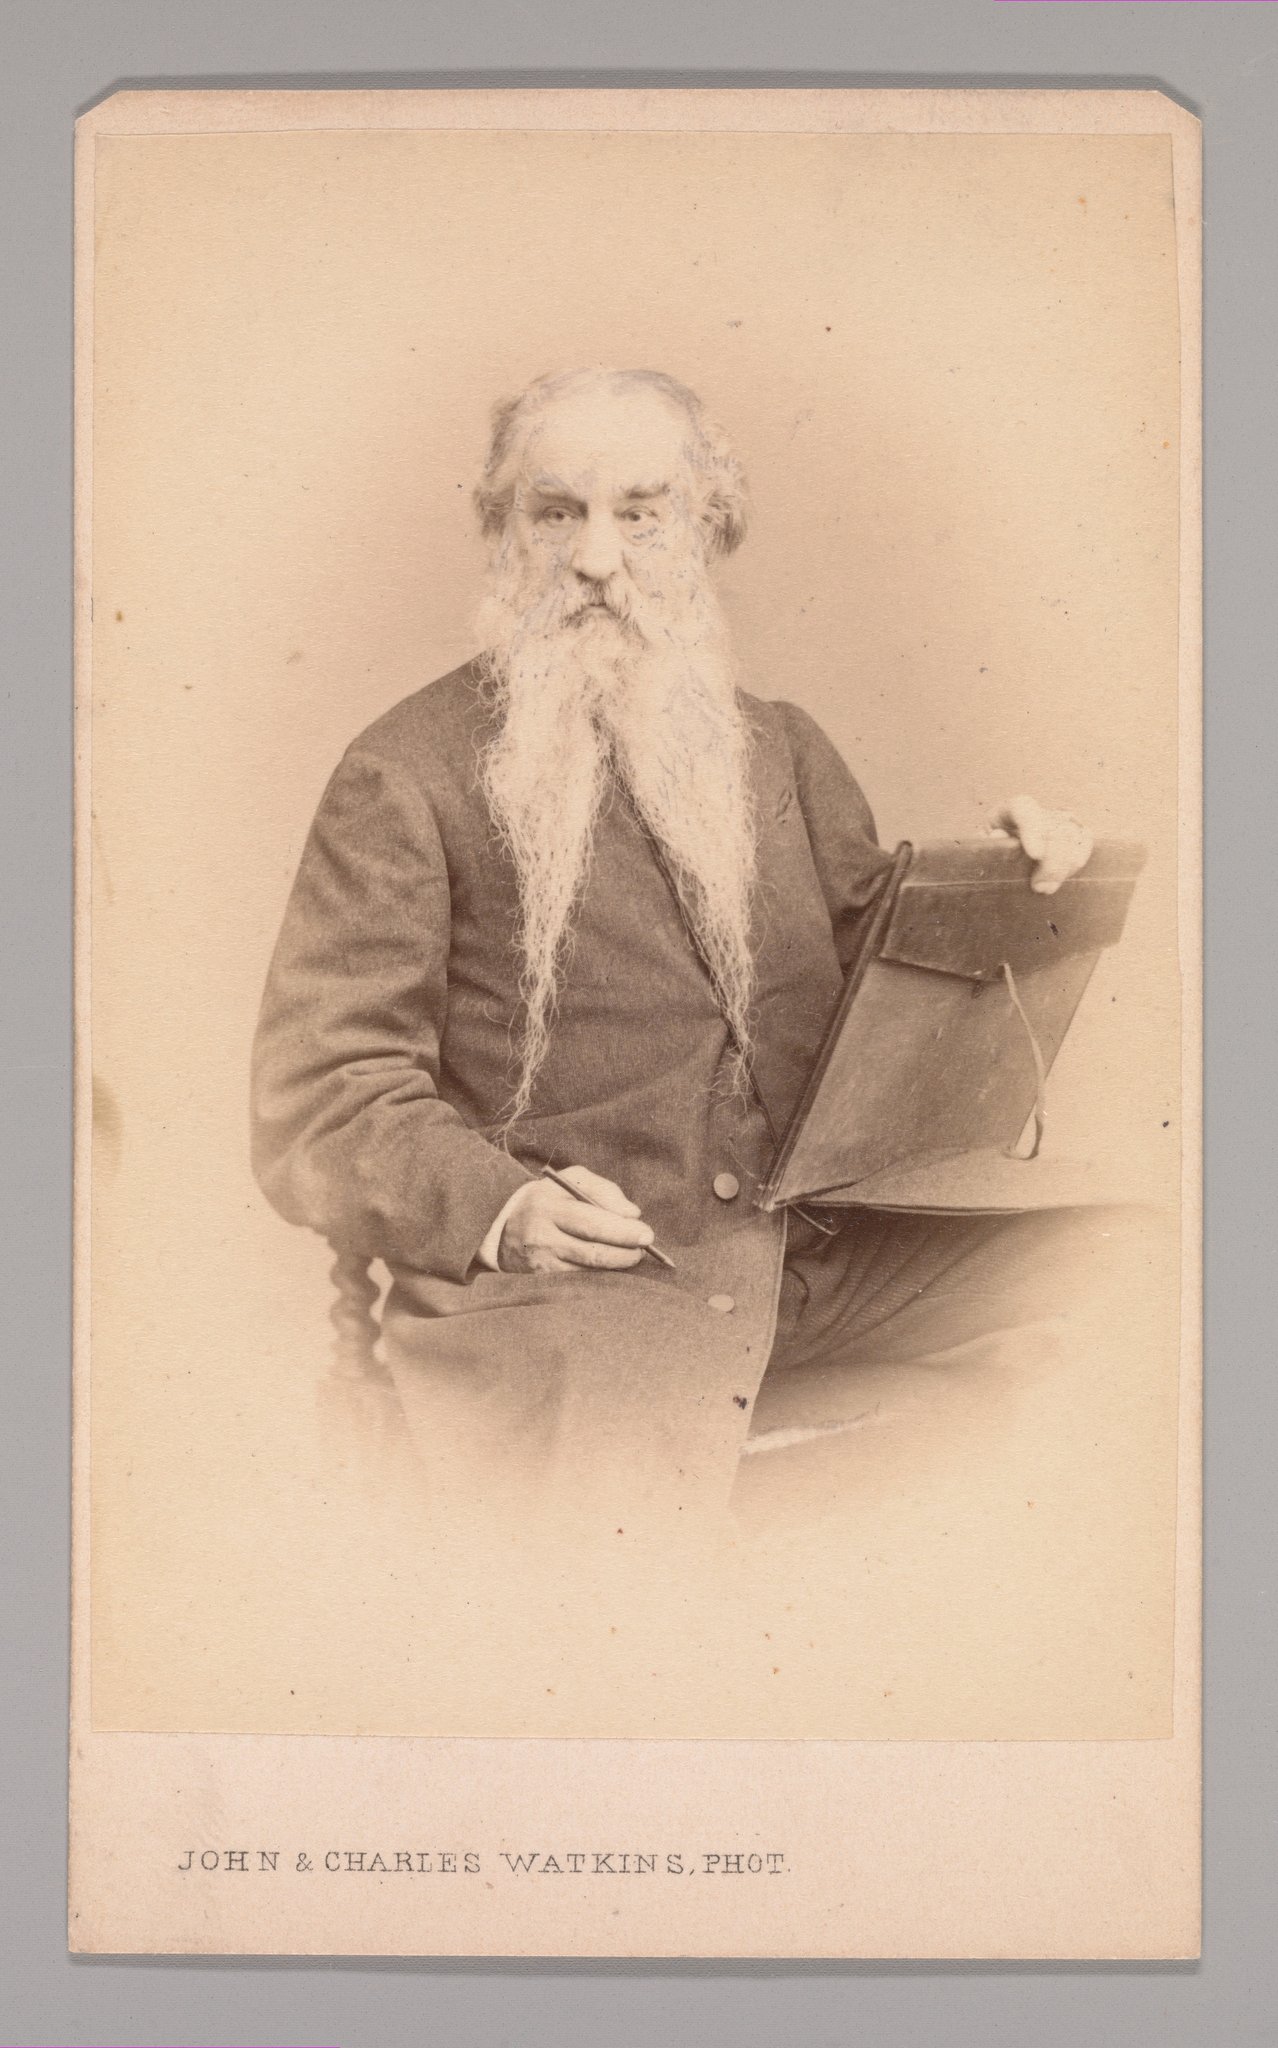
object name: carte de visite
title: [James Baker Pyne]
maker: john and charles watkins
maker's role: photography studio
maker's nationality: british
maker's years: 1840-1875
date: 1860-1869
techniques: albumen silver print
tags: men,portraits